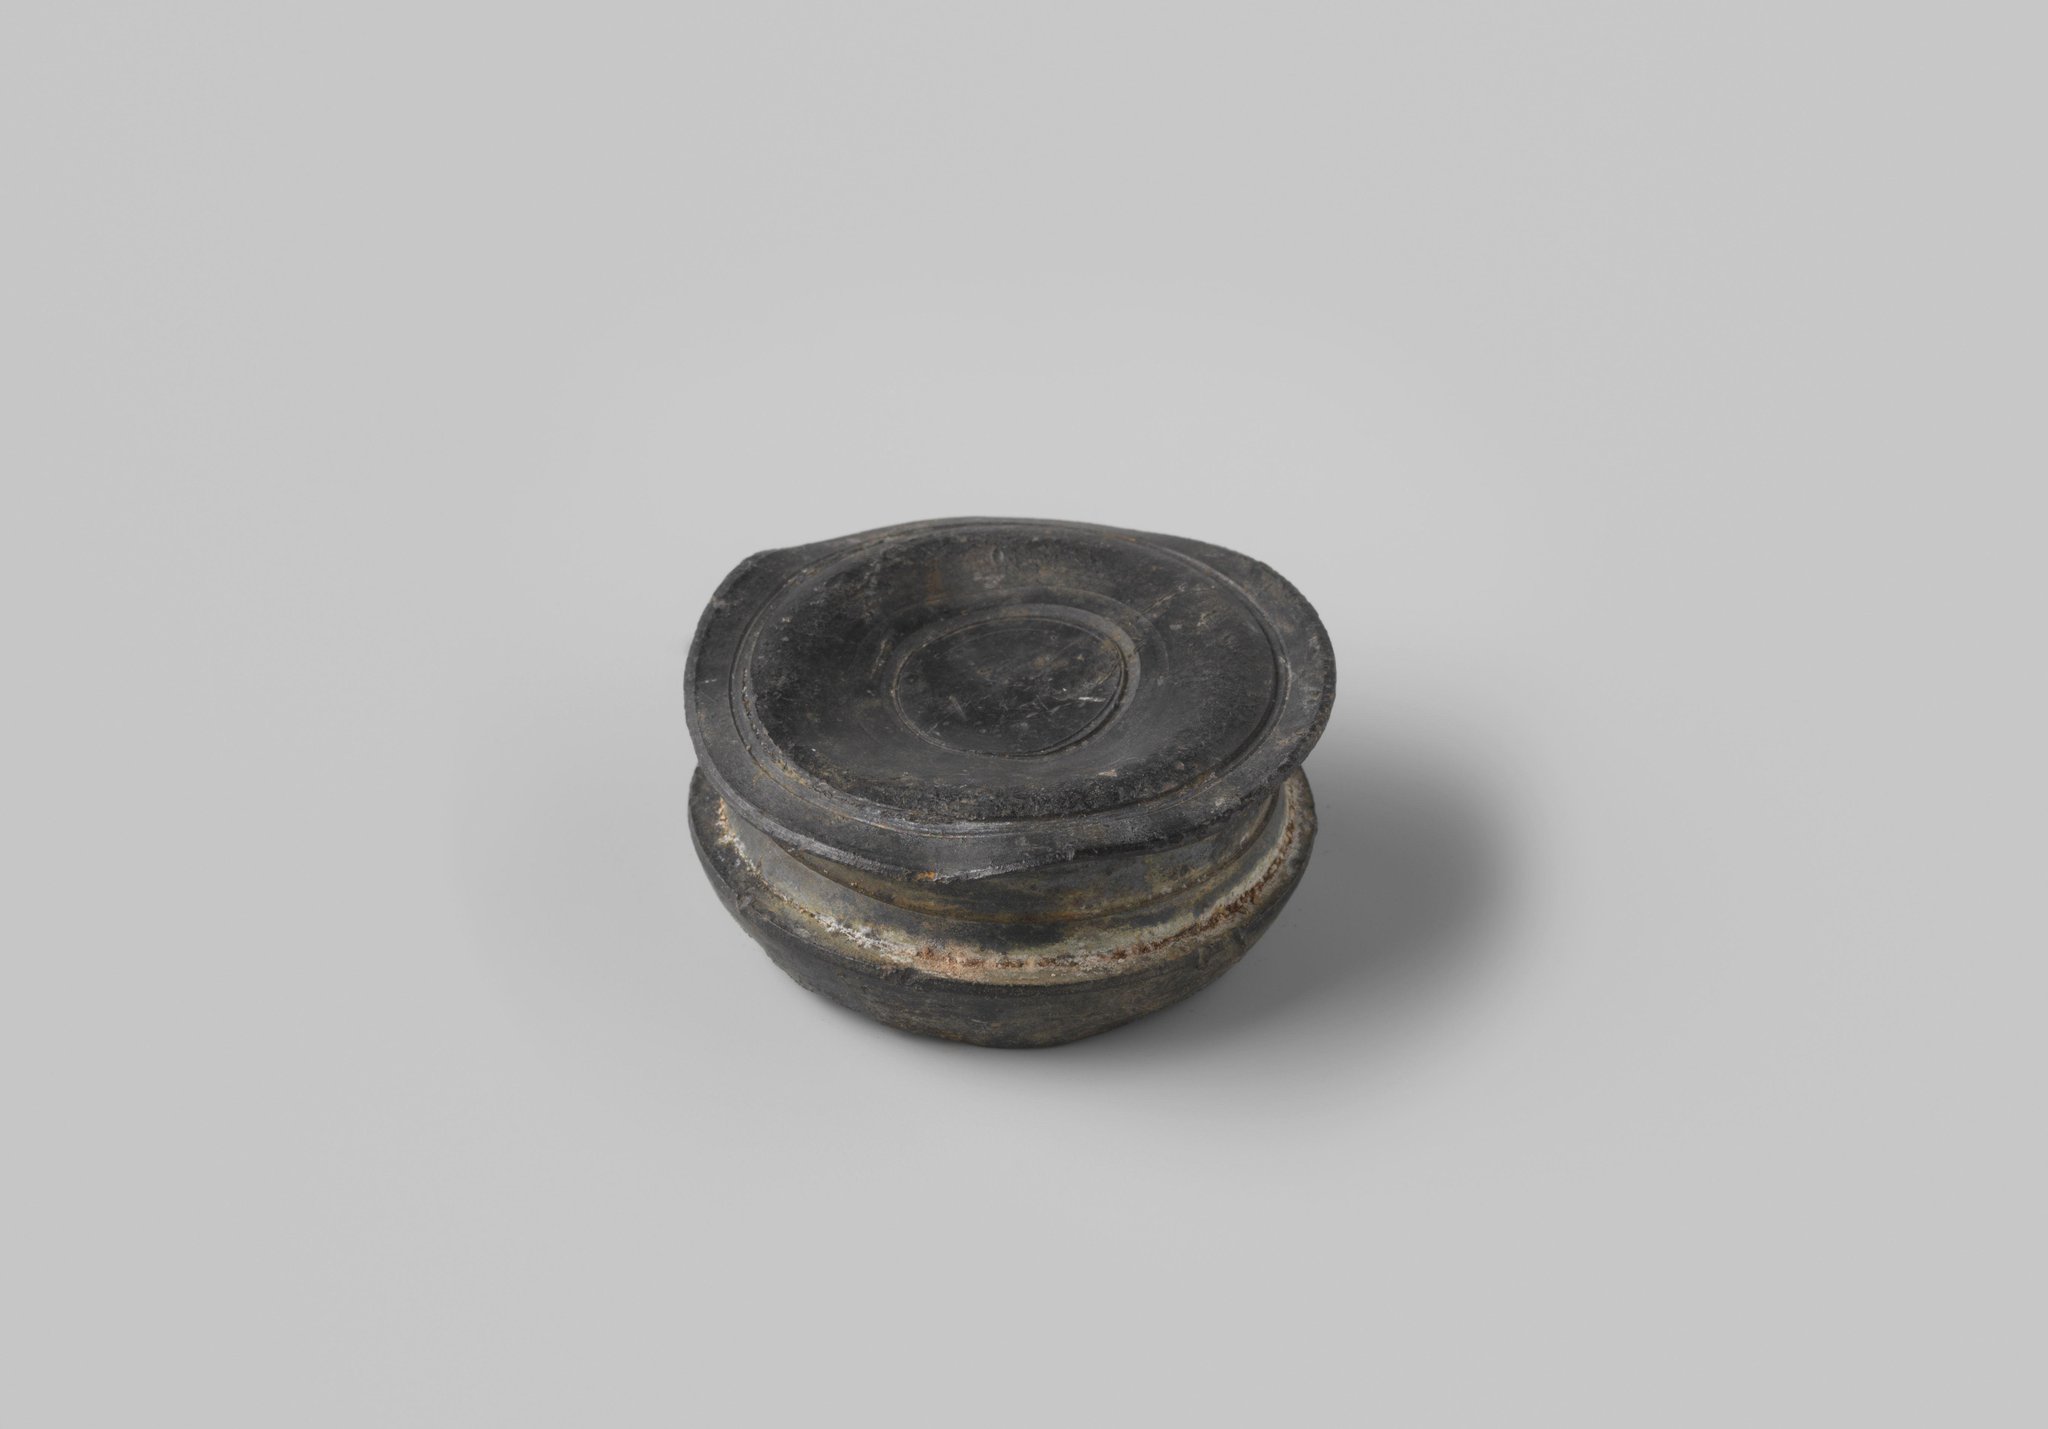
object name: screwcap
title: Schroefdop van een kelderfles uit het wrak van de Oost-Indiëvaarder Hollandia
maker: Anonymous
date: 1700-1743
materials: tin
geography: netherlands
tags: verenigde oostindische compagnie, hollandia (schip), annet